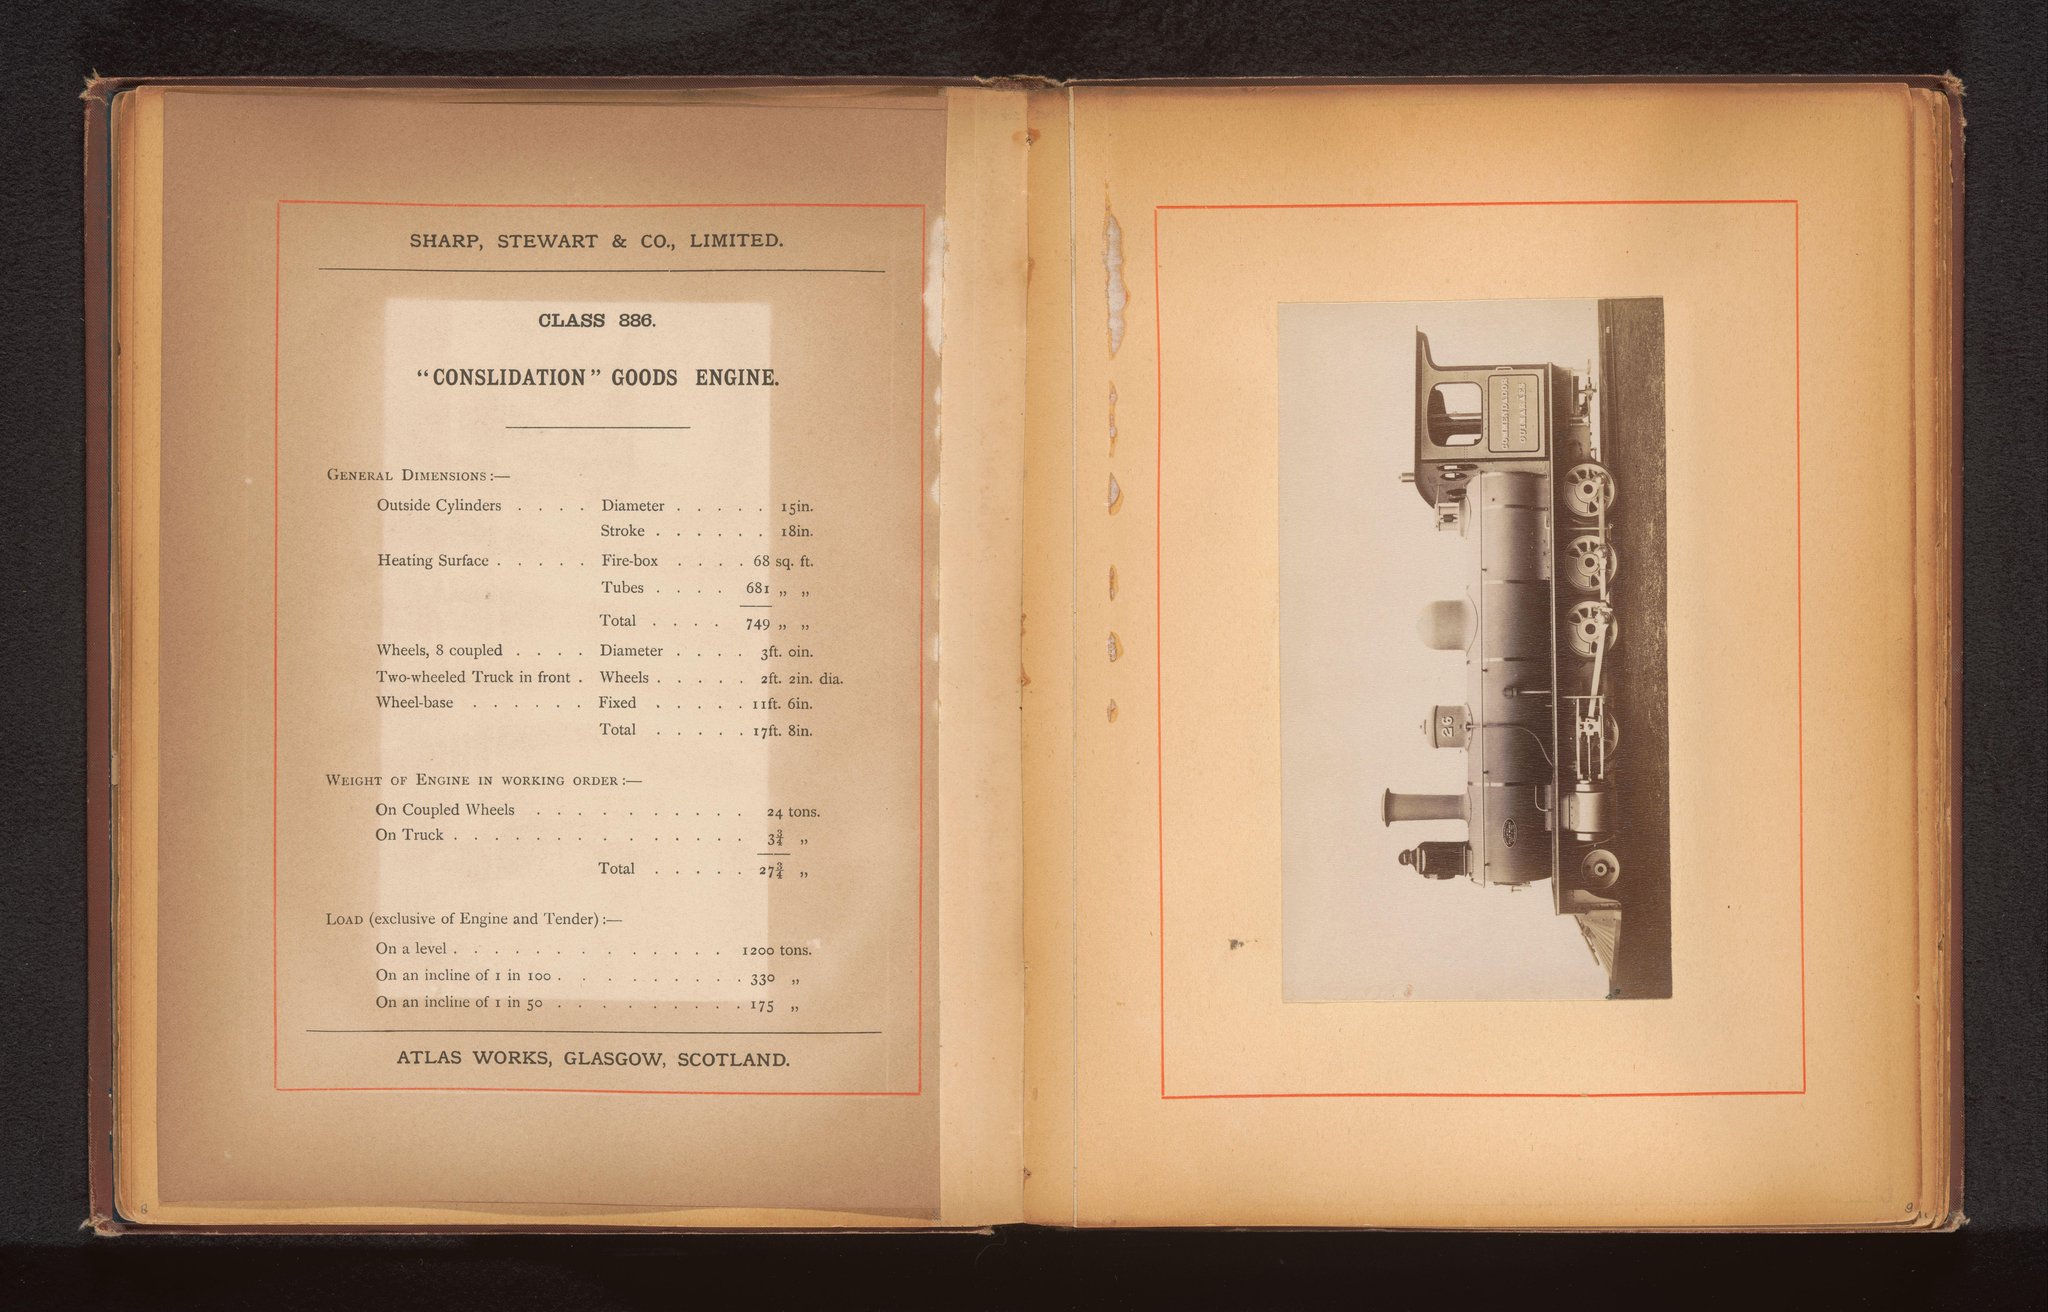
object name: page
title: Stoomlocomotief voor goederenvervoer gemaakt door Sharp, Stewart and Company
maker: Anonymous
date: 1874-1884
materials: photographic support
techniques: albumen print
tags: steam locomotive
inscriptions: number: ‘886’, inscription: ‘Class 886. “Conslidation” goods engine.’